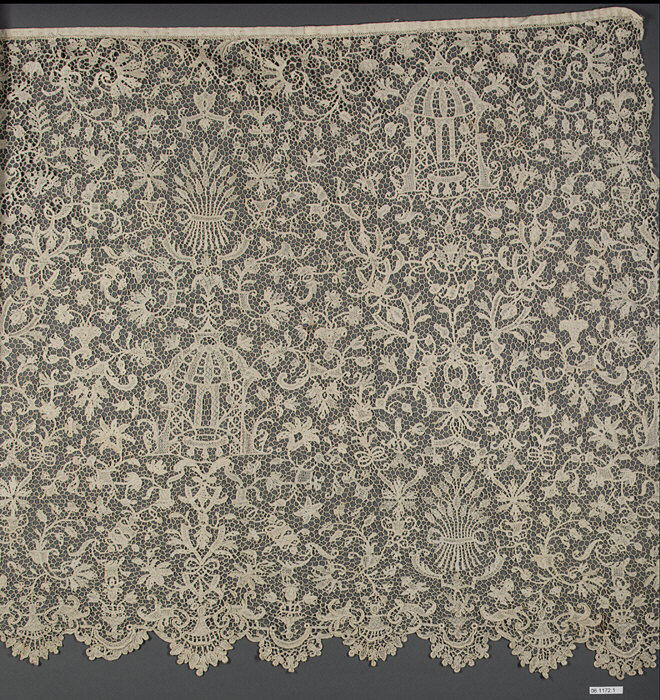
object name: flounce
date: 1715-1724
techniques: lace